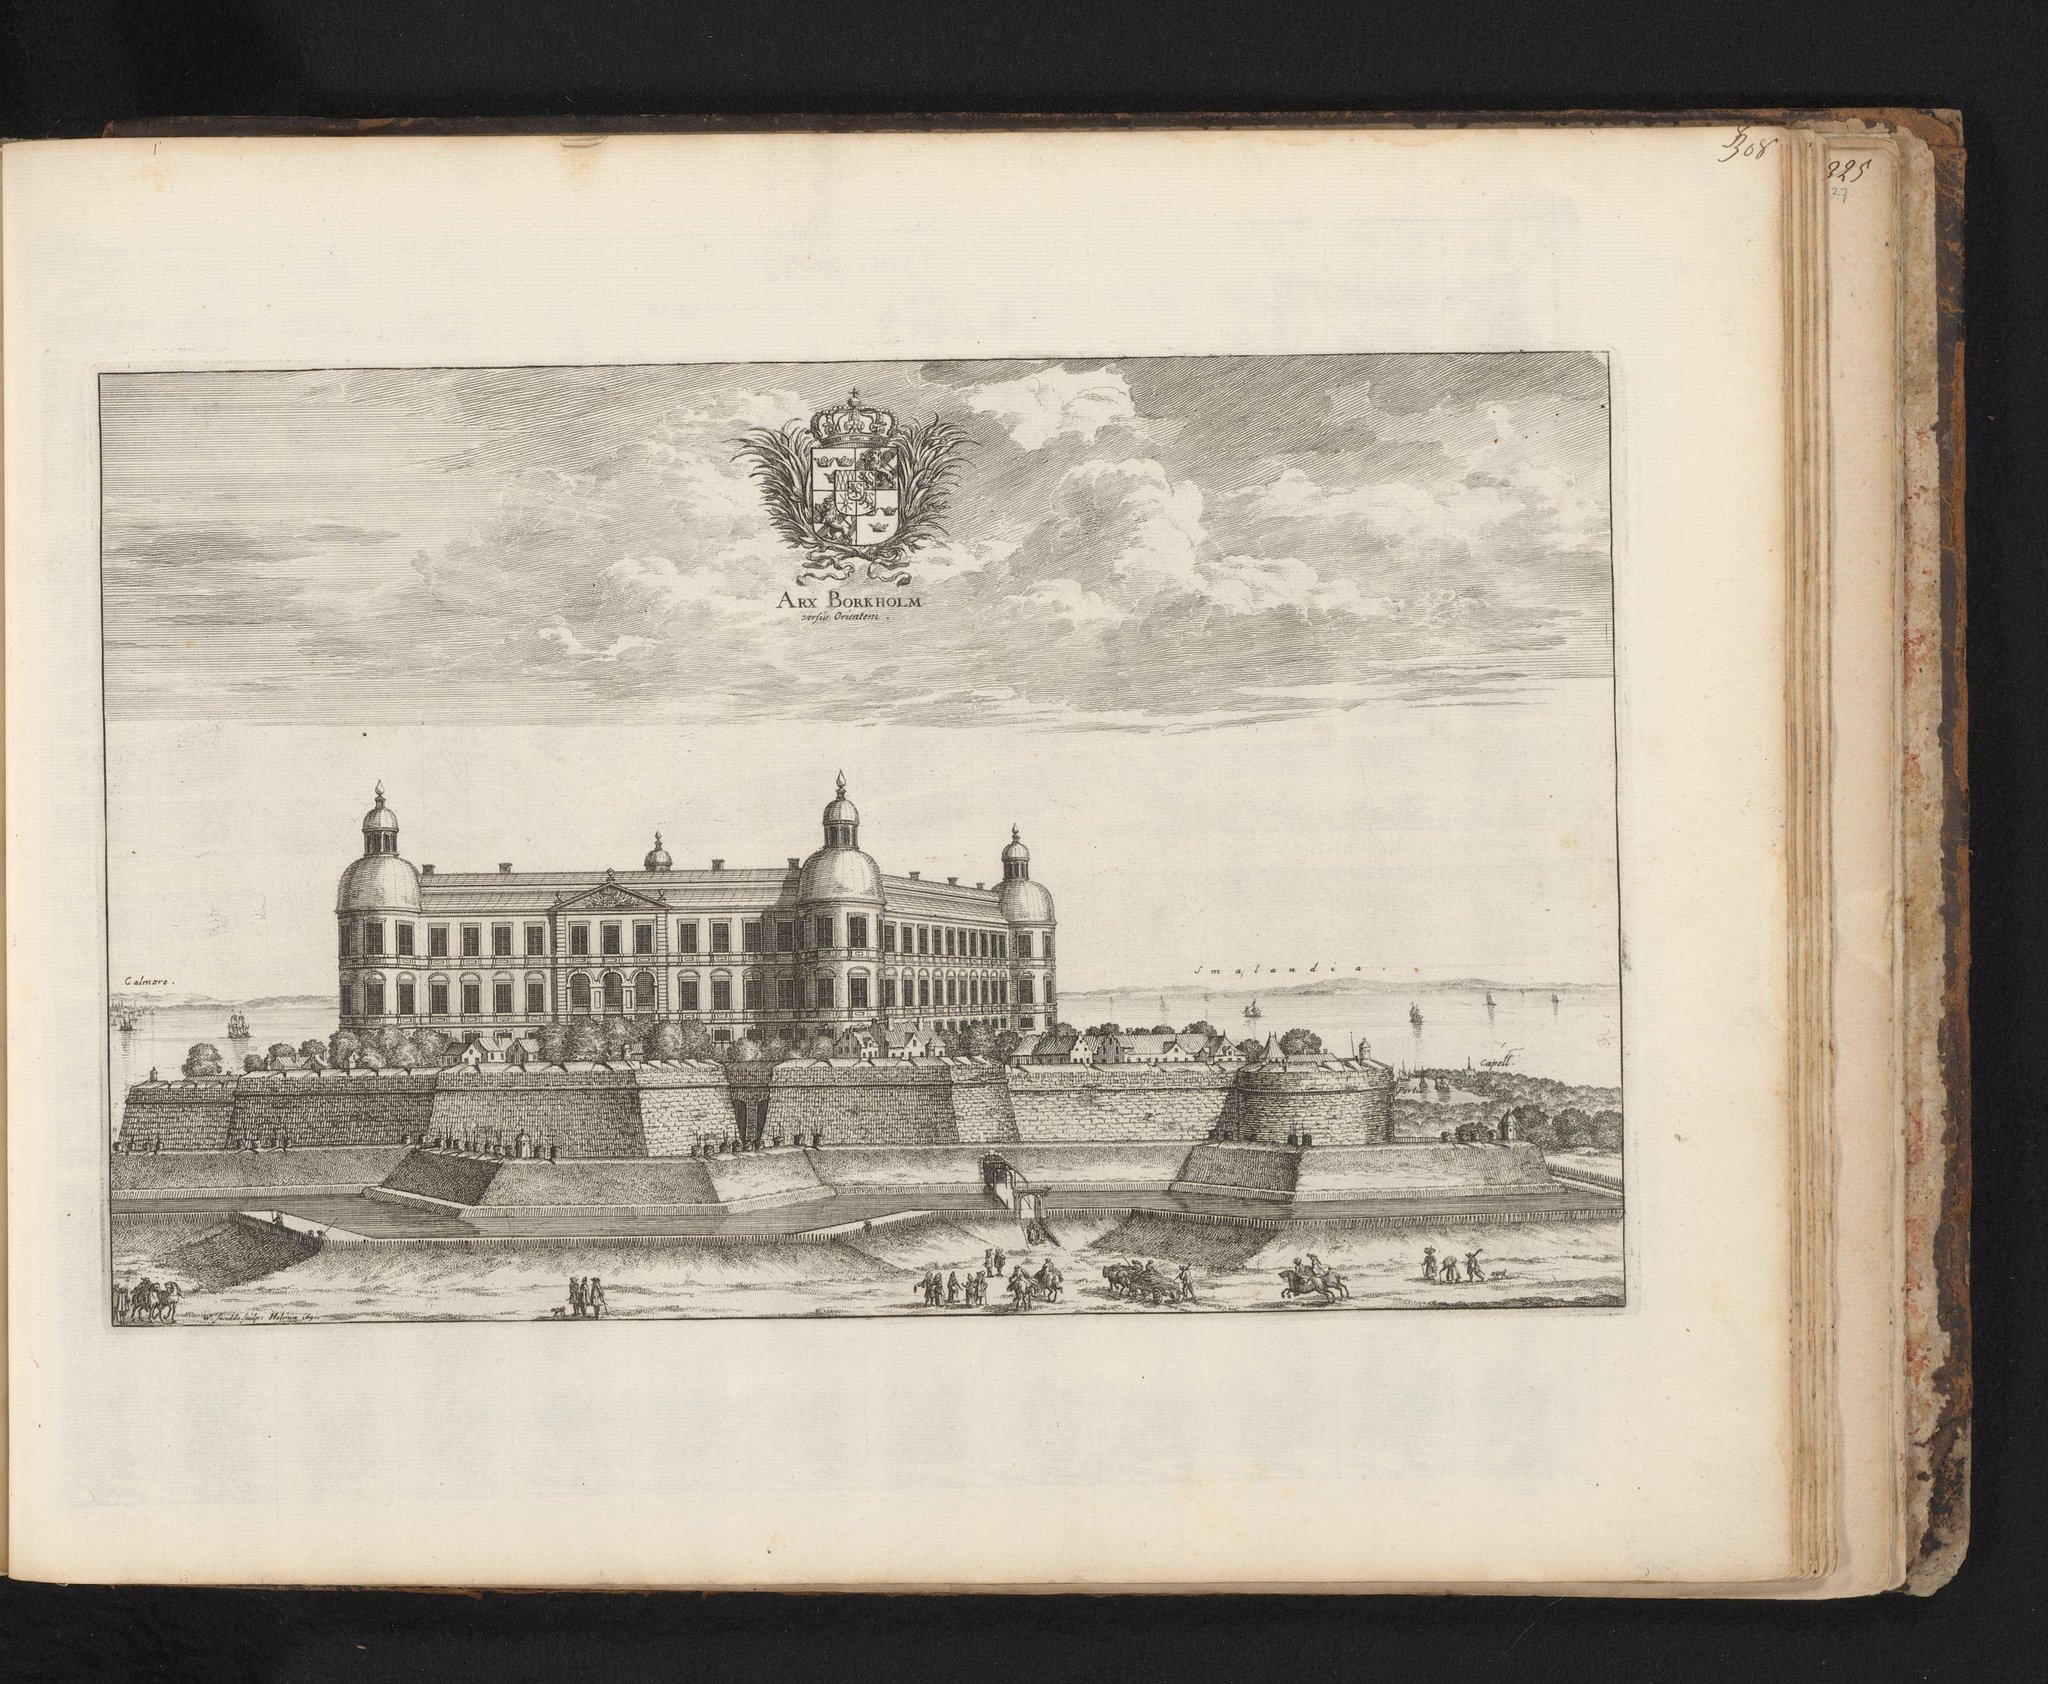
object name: print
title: Gezicht op kasteel Borgholm, vanuit het oosten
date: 1691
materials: paper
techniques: etching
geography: stockholm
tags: castle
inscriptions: date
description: Kungliga Biblioteket, 'Suecia': http://www.kb.se/samlingarna/Kartor-bilder/Suecia-antiqua/ (geraadpleegd november 2016).